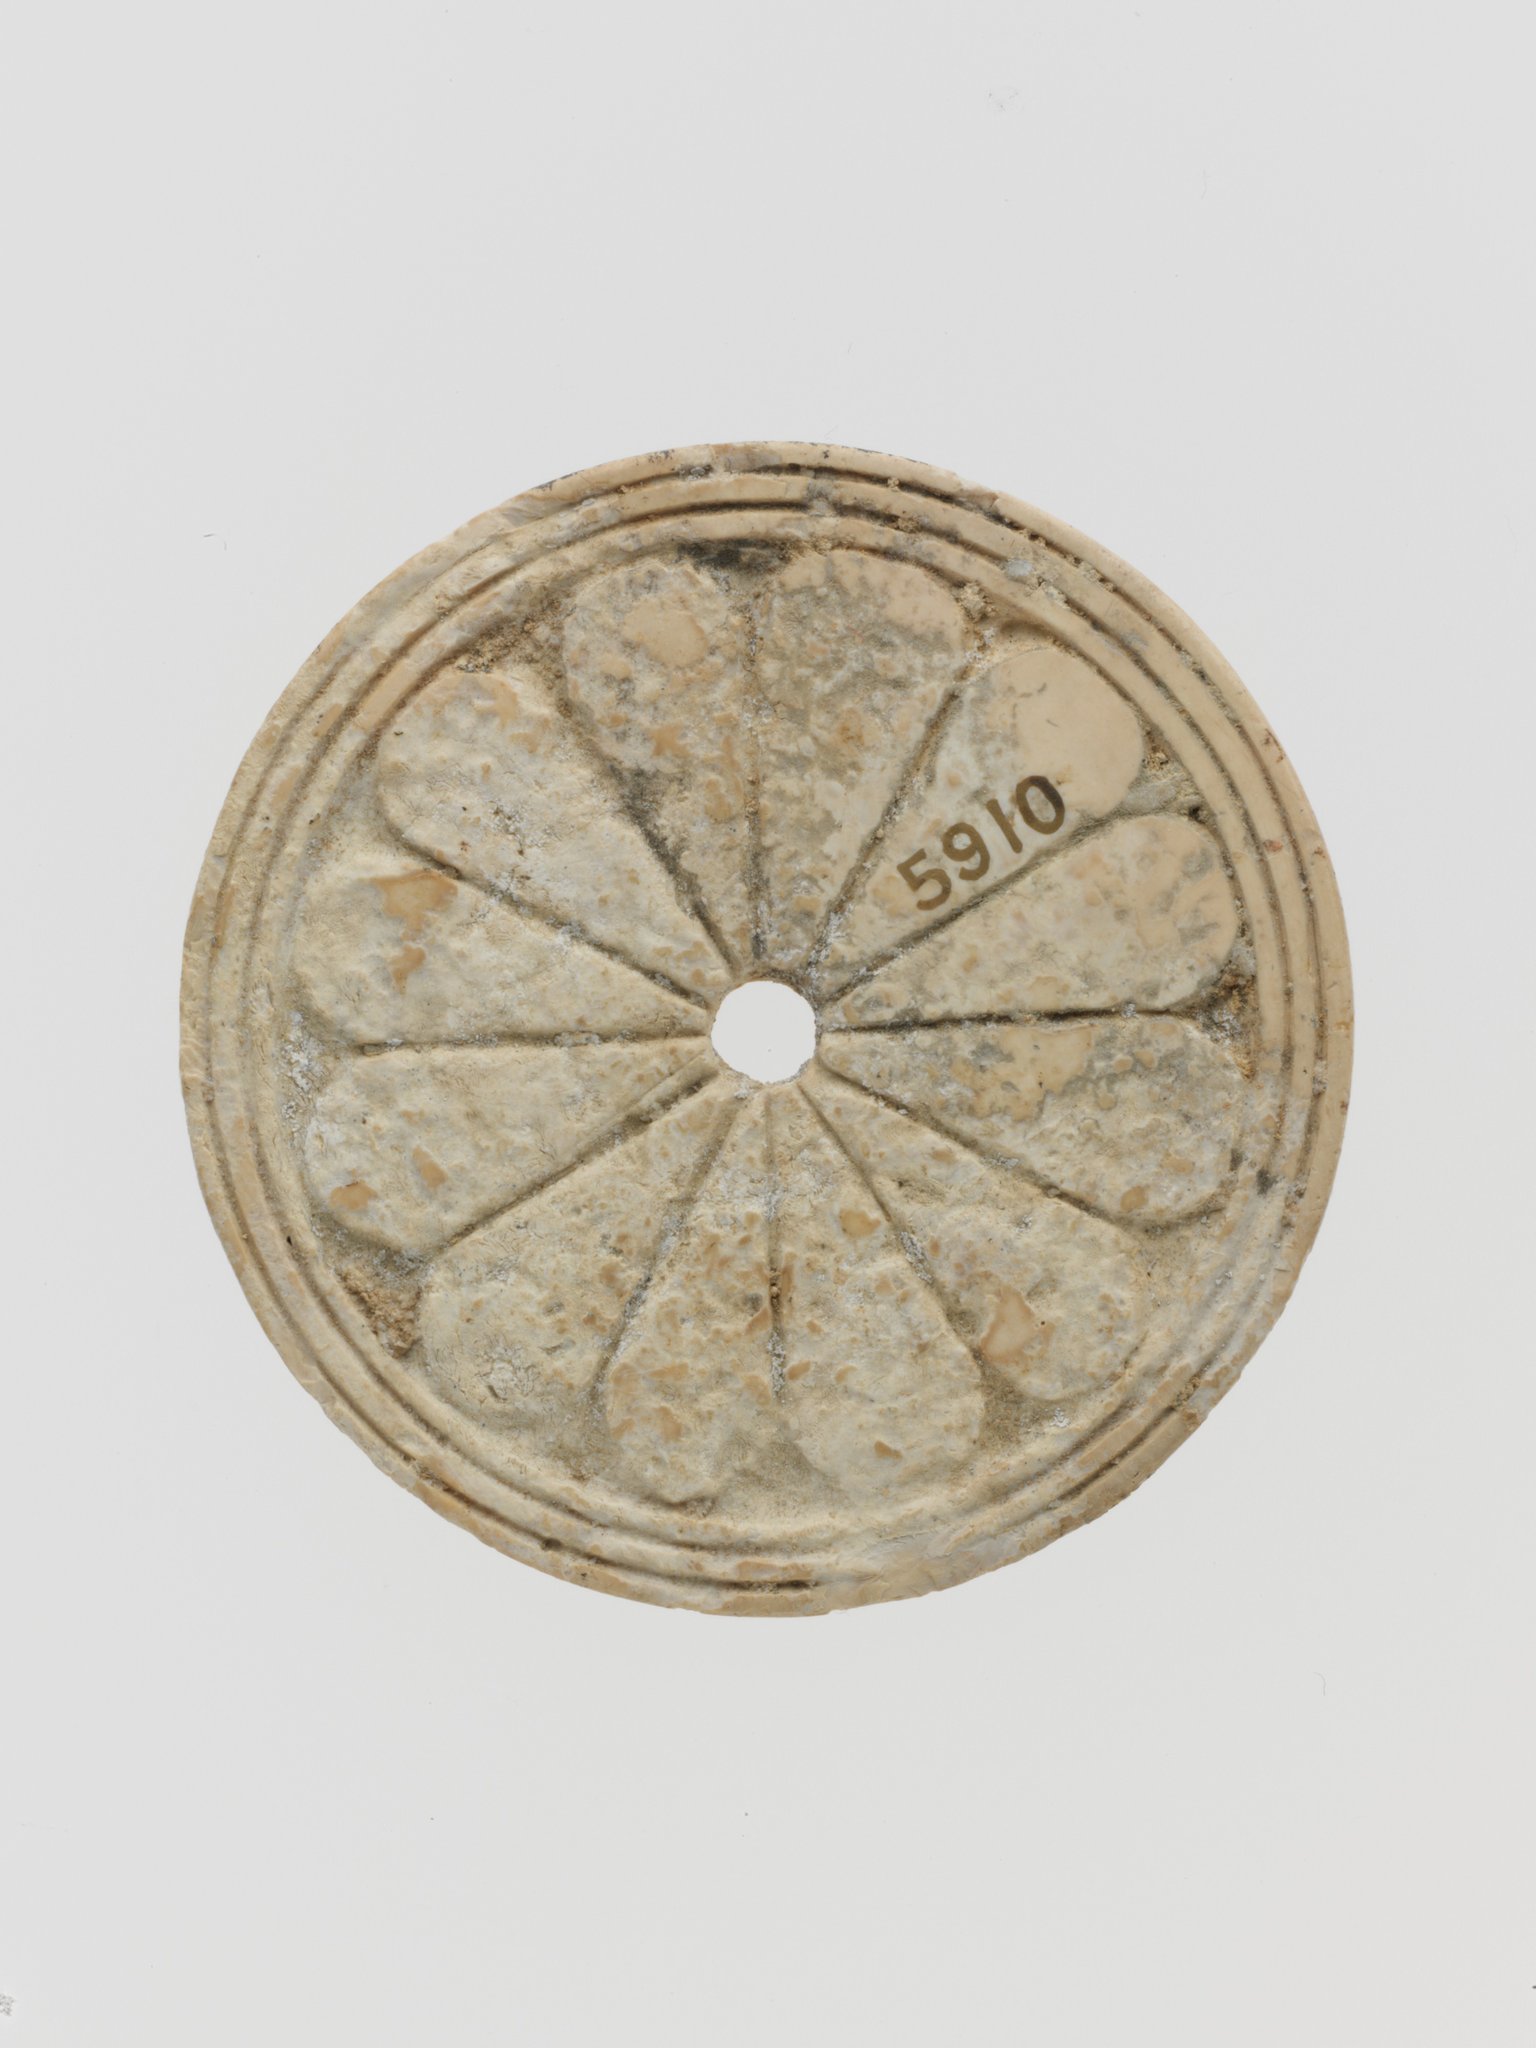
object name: roundel, disk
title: Ivory disk of a pyxis with rosette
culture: cypriot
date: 1300-1101 BCE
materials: ivory